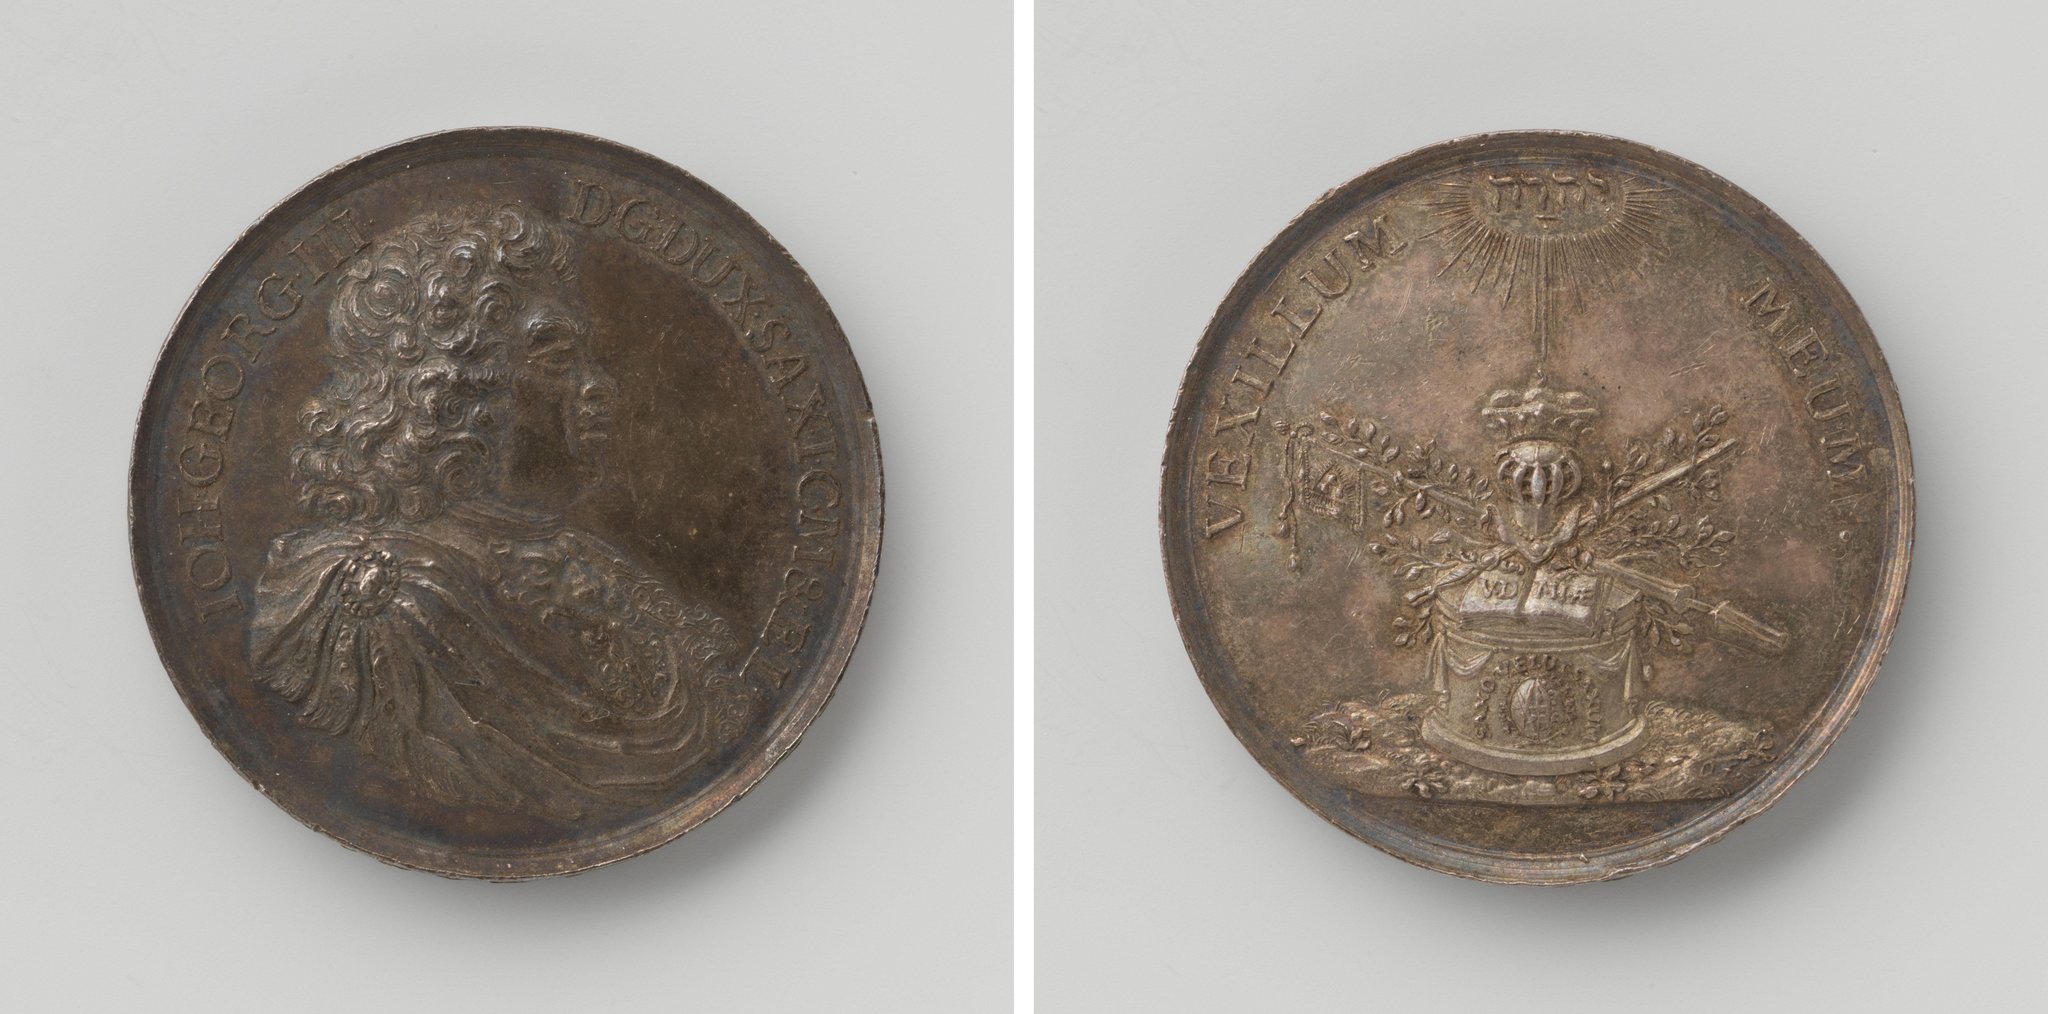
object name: history medal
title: Johan Georg III, hertog van Saksen trekt over de Rijn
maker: Anonymous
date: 1691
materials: silver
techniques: striking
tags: keurvorst van saksen johan georg iii, rijn, johan georg iii steekt rijn over, negenjarige oorlog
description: Zilveren penning. Voorzijde: borststuk man binnen omschrift. Keerzijde: keurvorstelijke helm, Franse standaard en degen omwonden met lauwertakken liggend op altaar beschenen door hemellicht binnen omschrift; randschrift